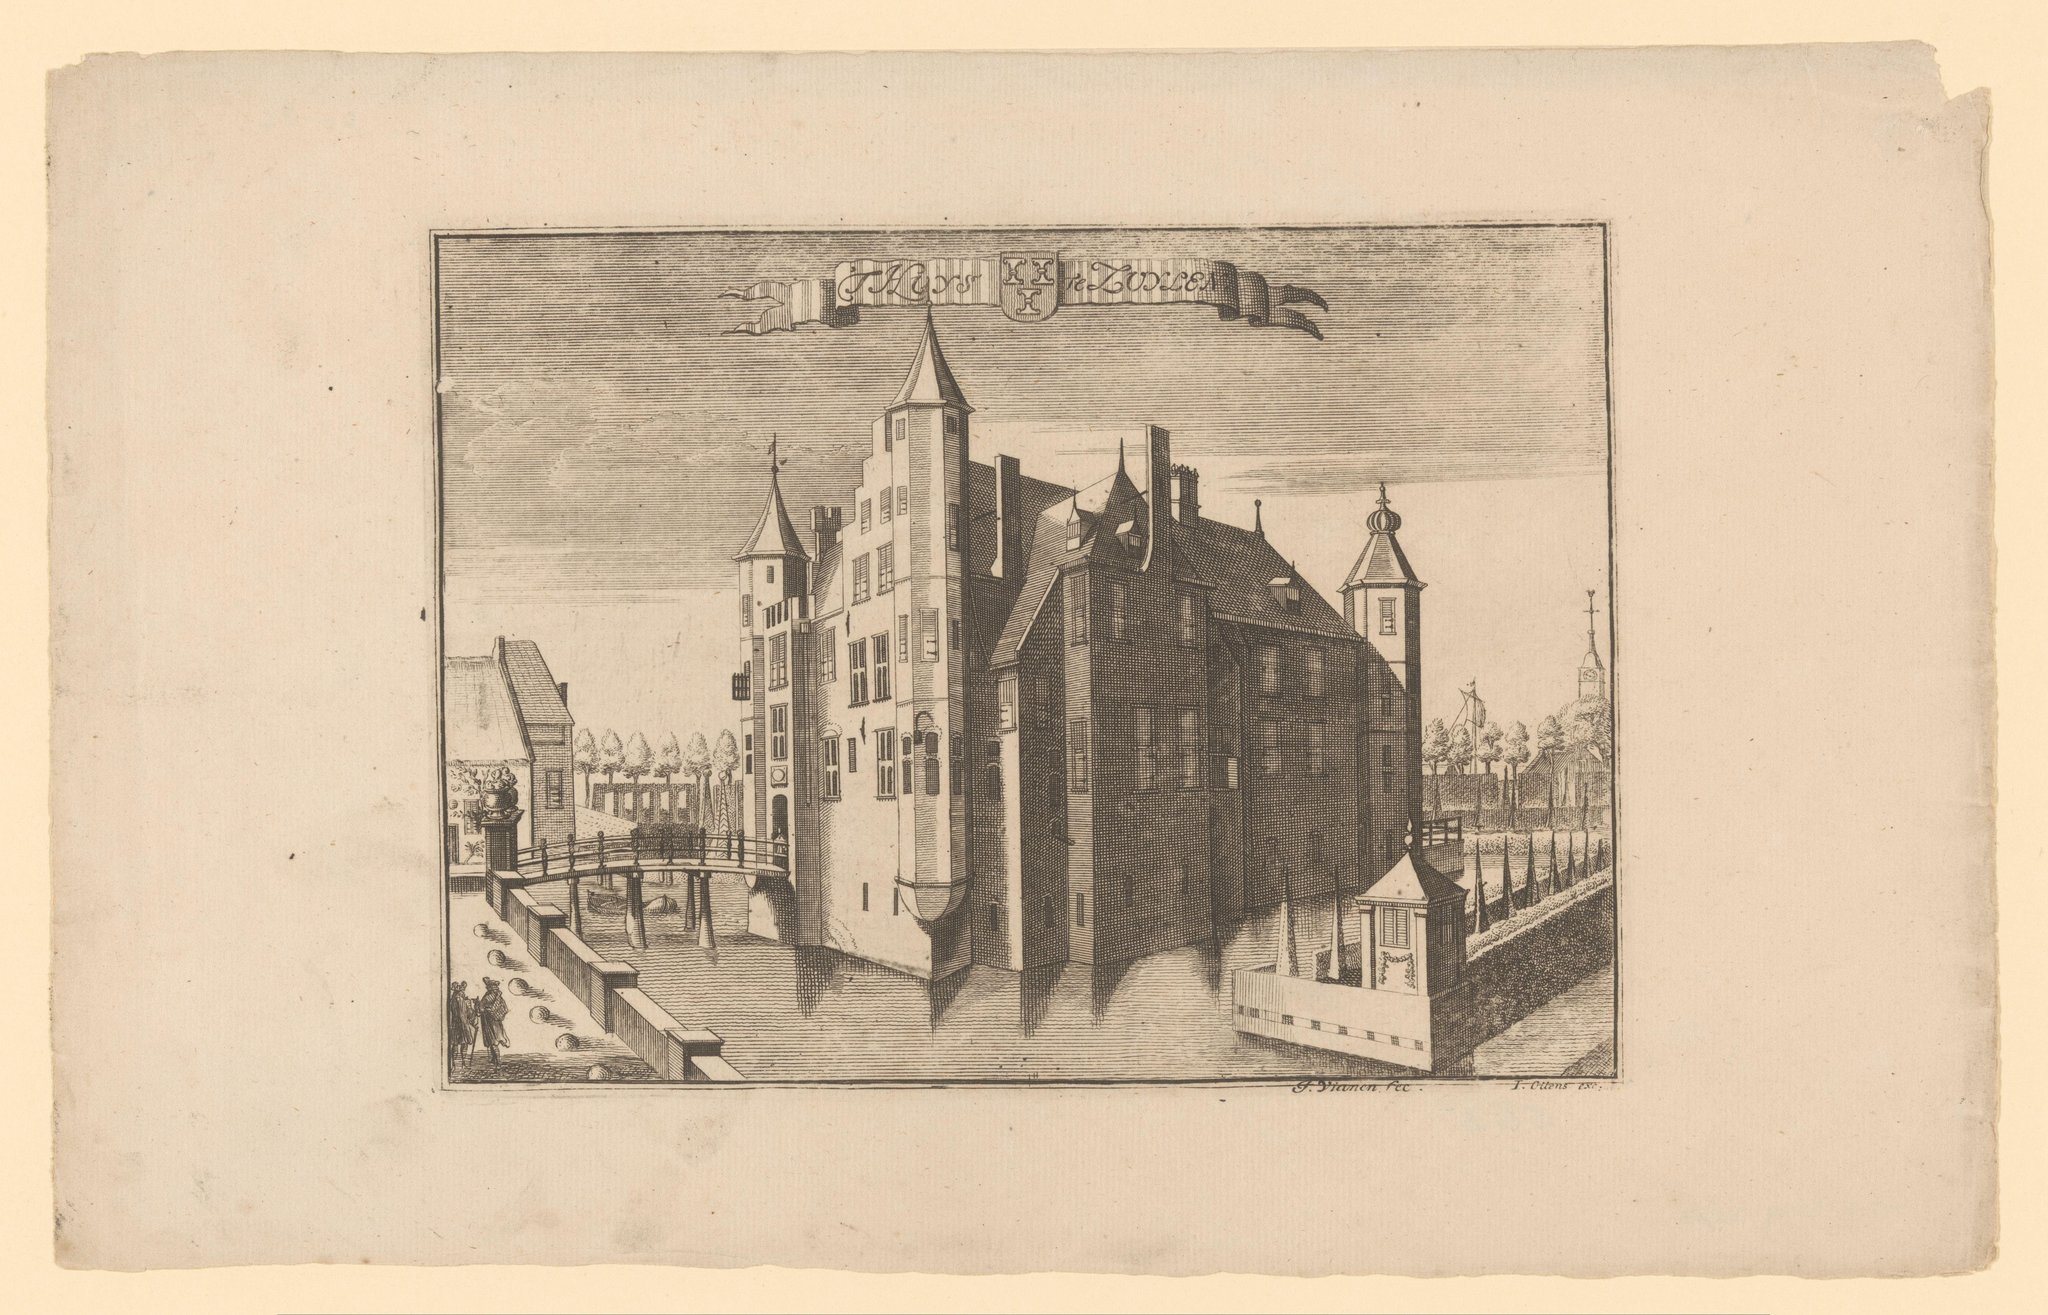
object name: print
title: 't Huys te Zuylen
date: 1710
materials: paper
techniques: engraving, etching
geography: utrecht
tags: castle, landscape with tower or castle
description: Prent uit: De Ridder-matige Huysen en Gesichten in de Provincie van Utrecht. Amsterdam: Joachim Ottens, [ca. 1710].